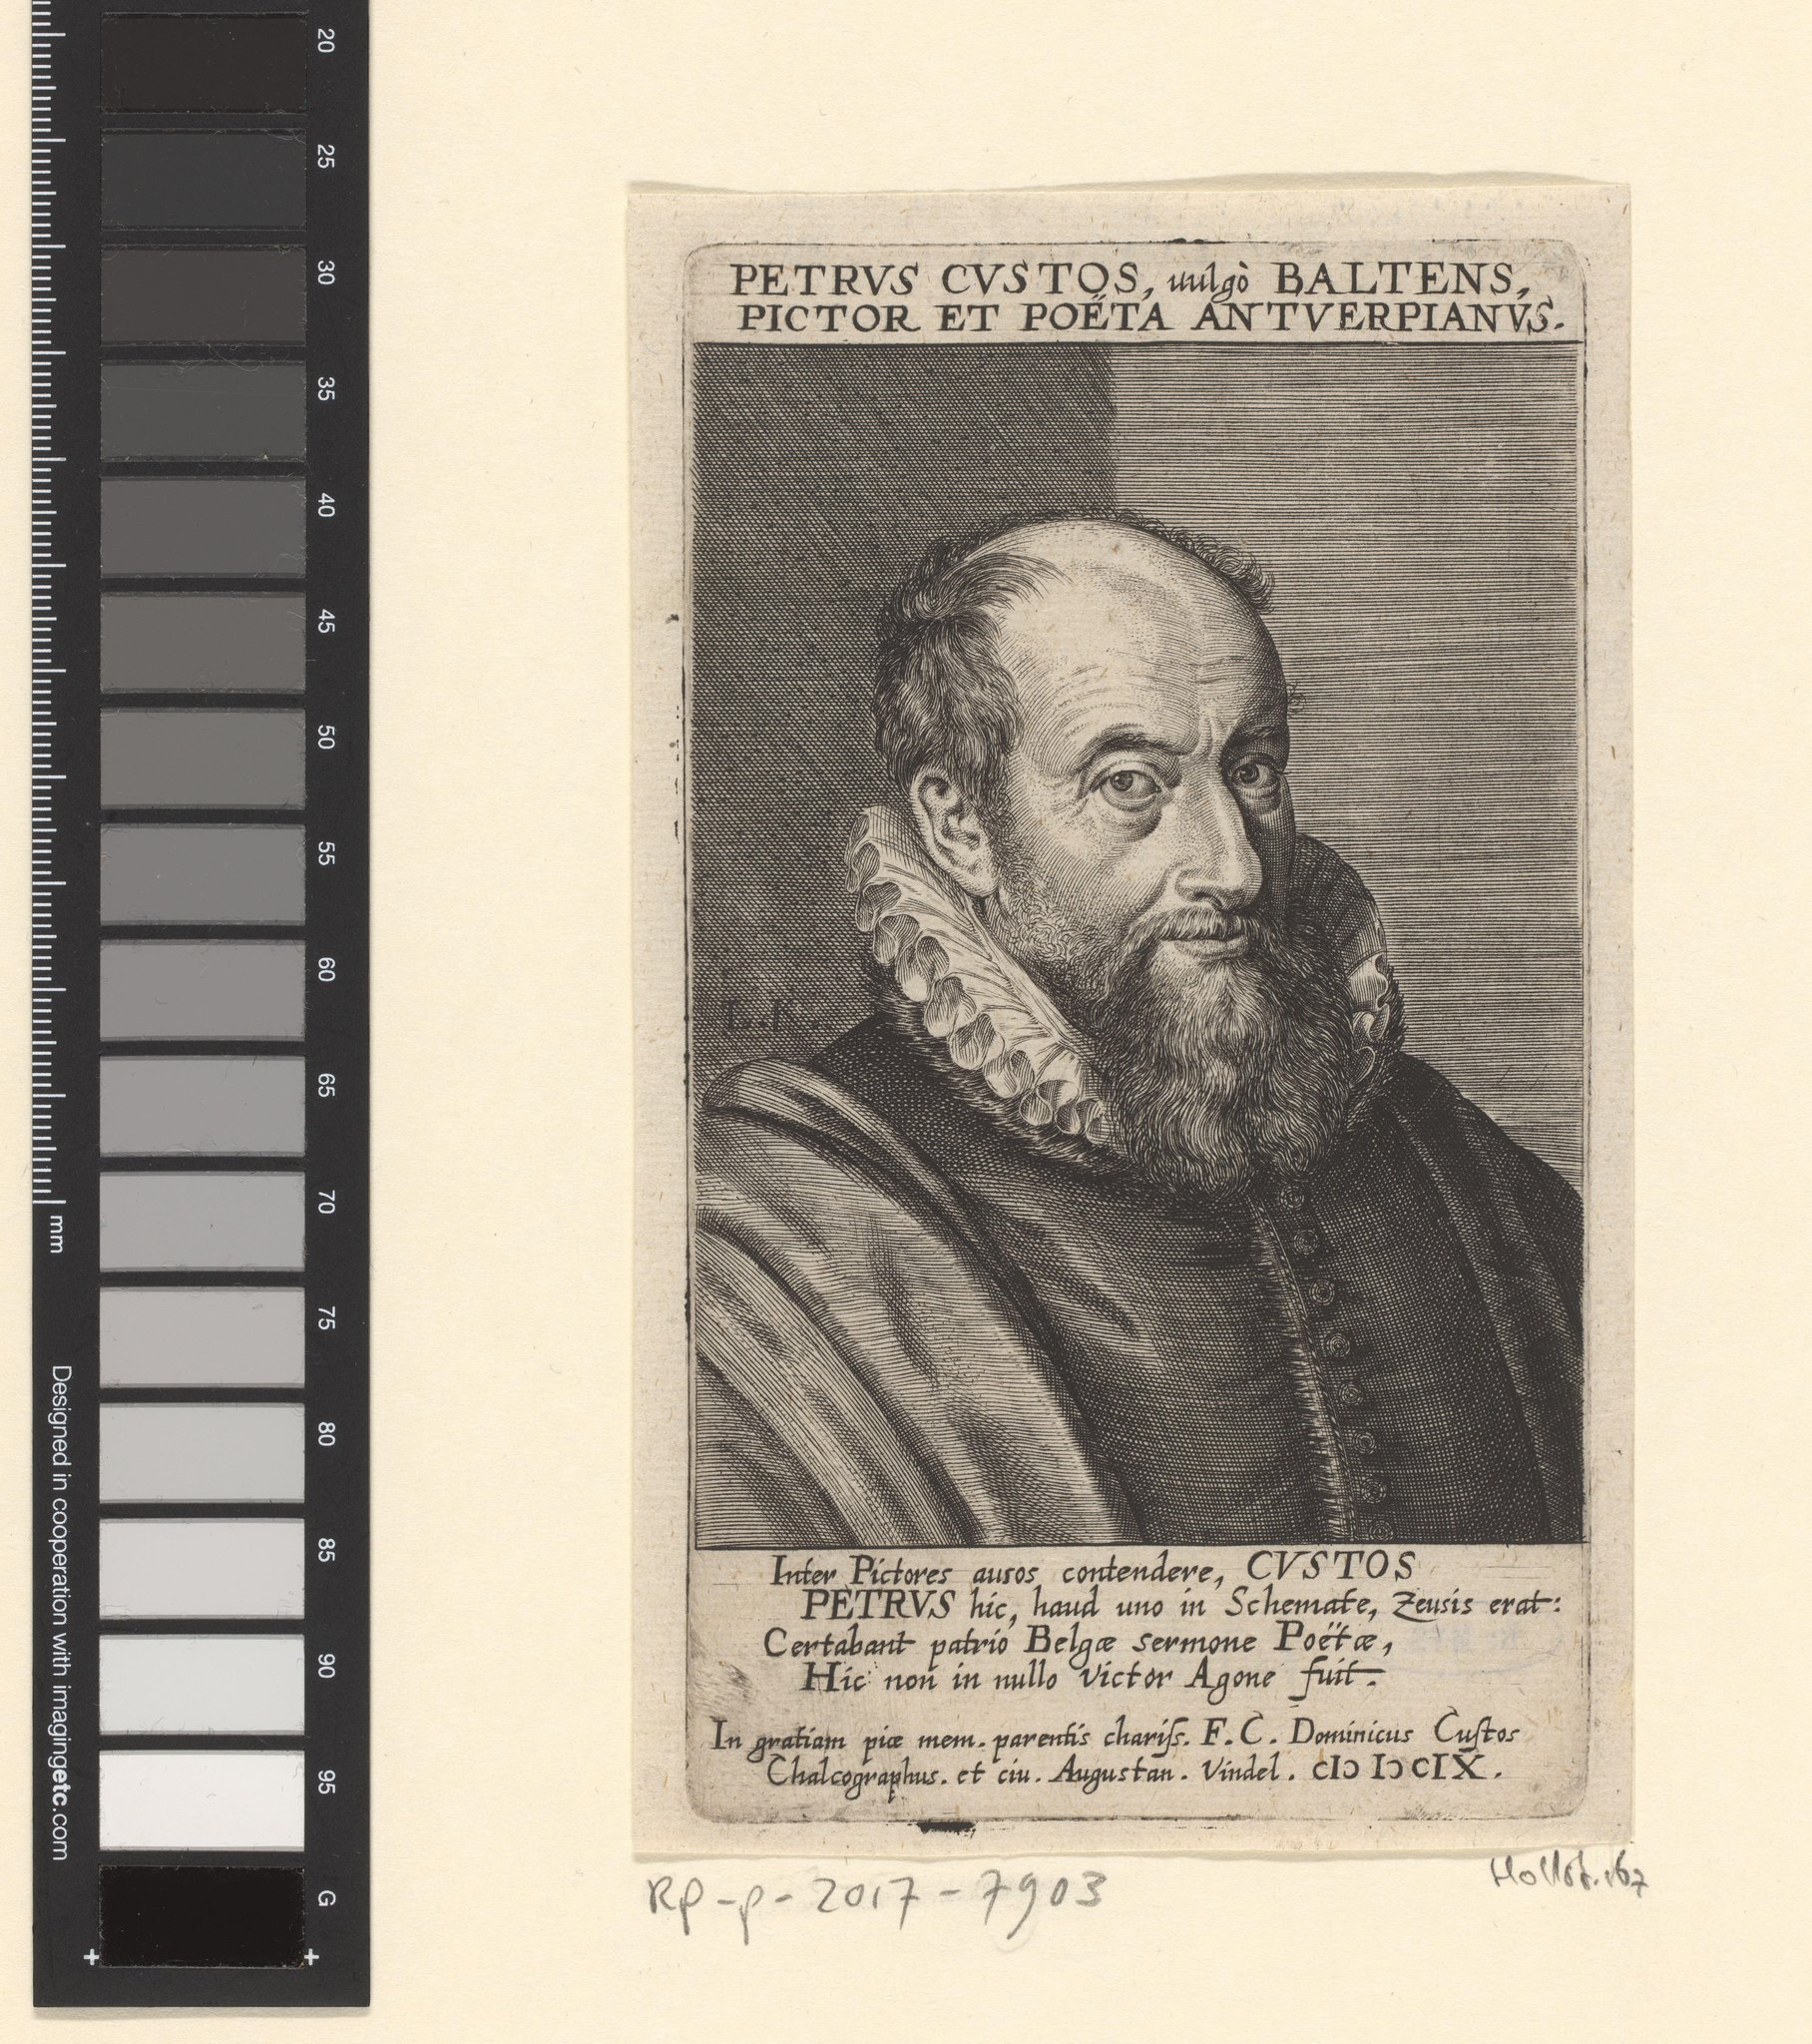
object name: print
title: Portret van Peeter Baltens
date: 1609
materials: paper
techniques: engraving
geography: augsburg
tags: antwerp, painter, print maker, draughtsman, publisher, peeter baltens, publishing, publisher (+ portrait of scholar, scientist), historical persons, portrait, self-portrait of graphic artist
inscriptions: collector's mark: Lugt 2228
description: Als stiefzoon van Dominicus Custos, is Peeter (Pieter) Baltens ook bekend als Petrus Custos.